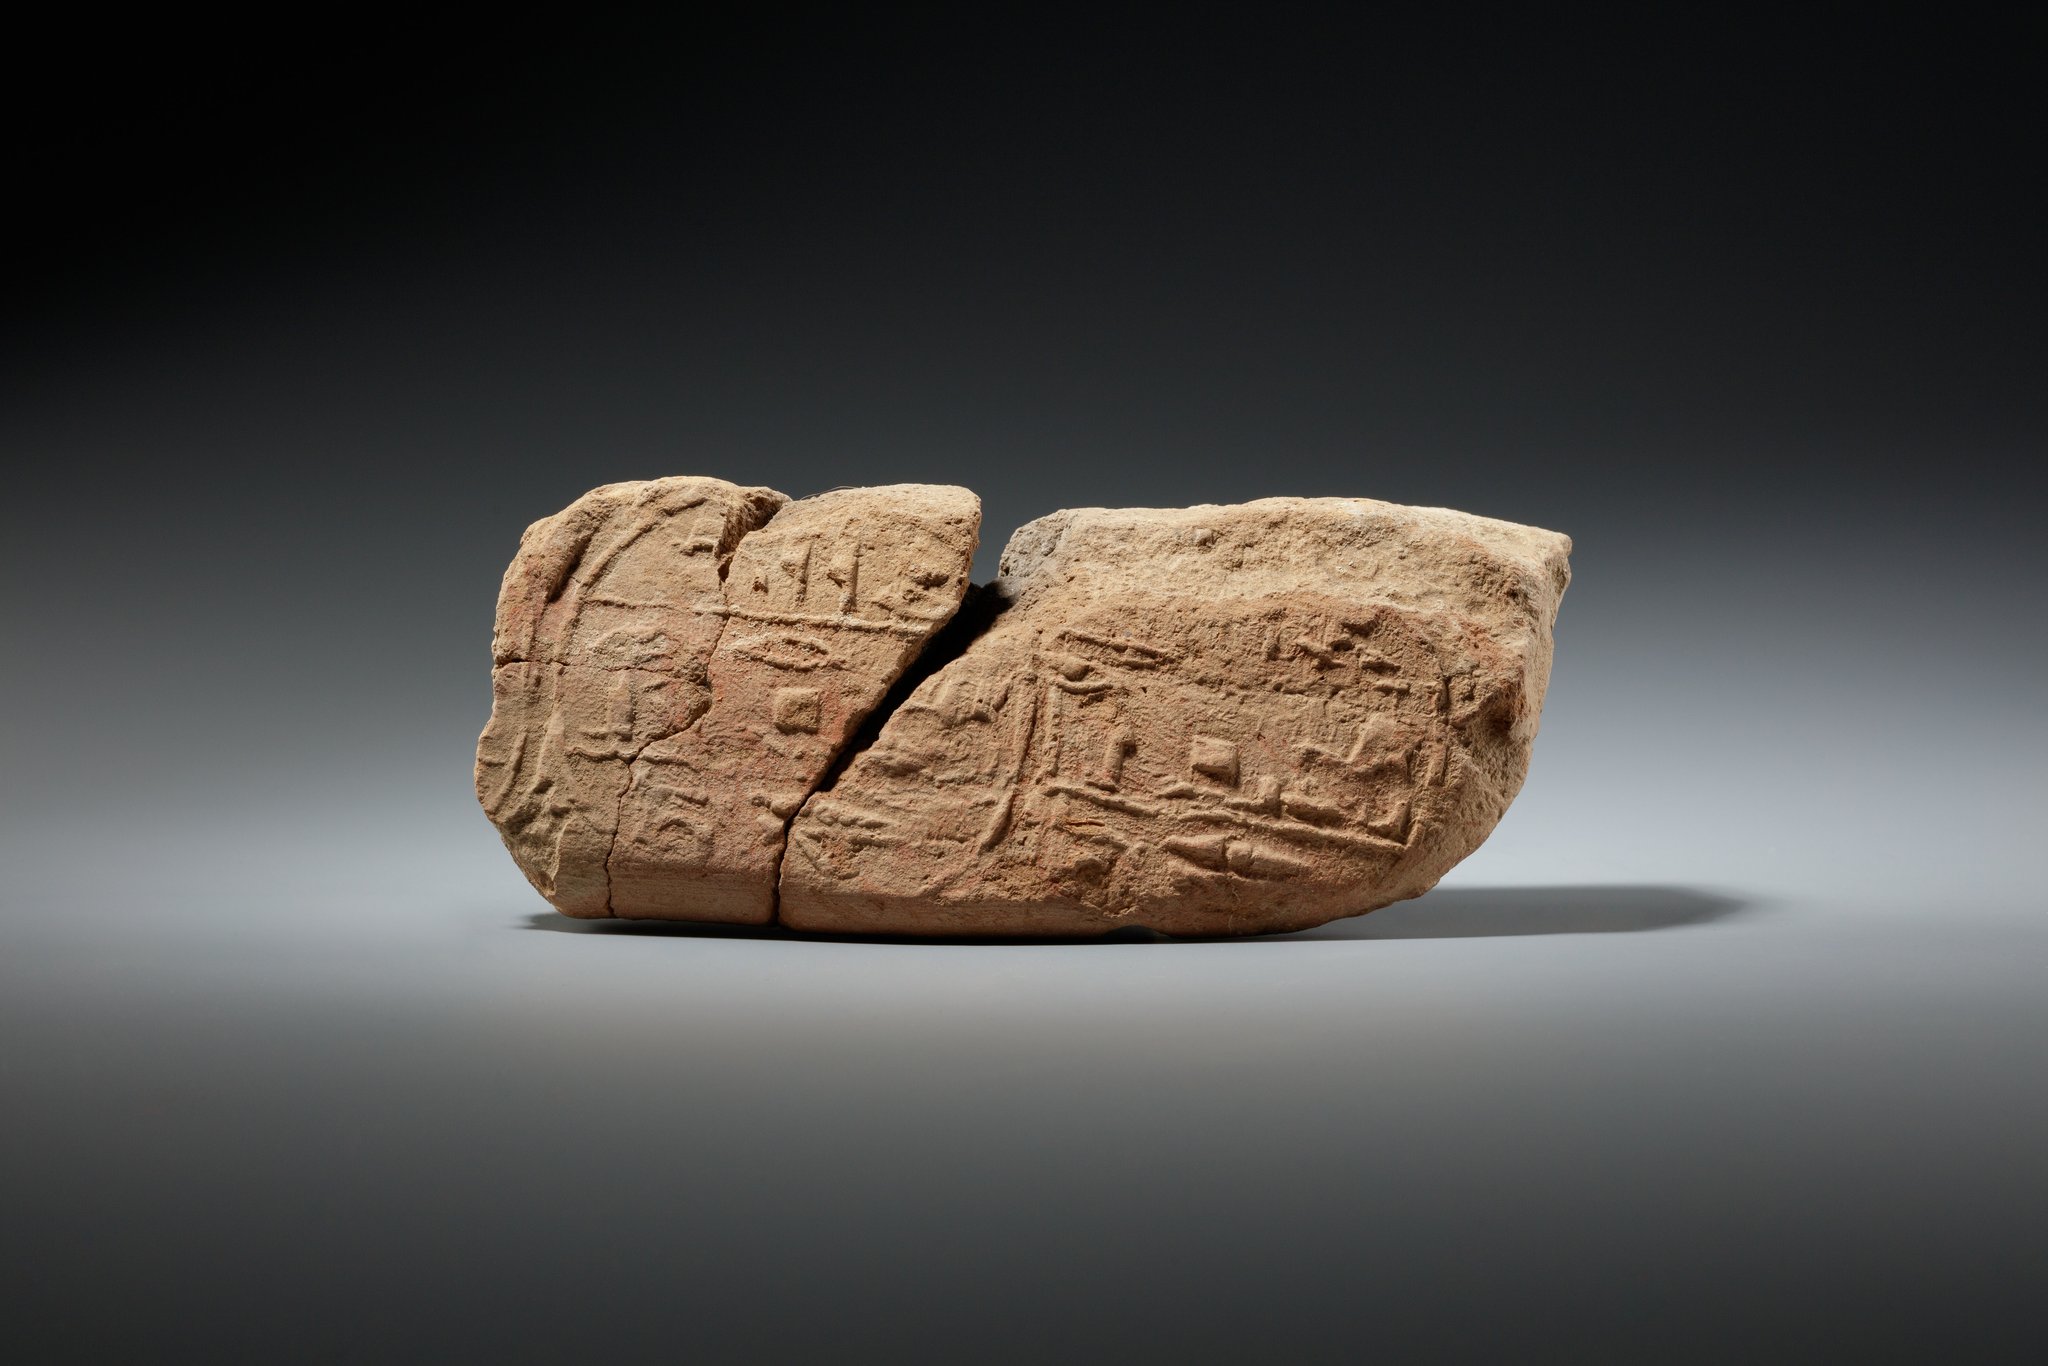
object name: cone, brick, davy 499, min, overseer, seal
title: Stamped Mud Brick with the Name Min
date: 1479-1458 BCE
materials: pottery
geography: egypt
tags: hieroglyphs